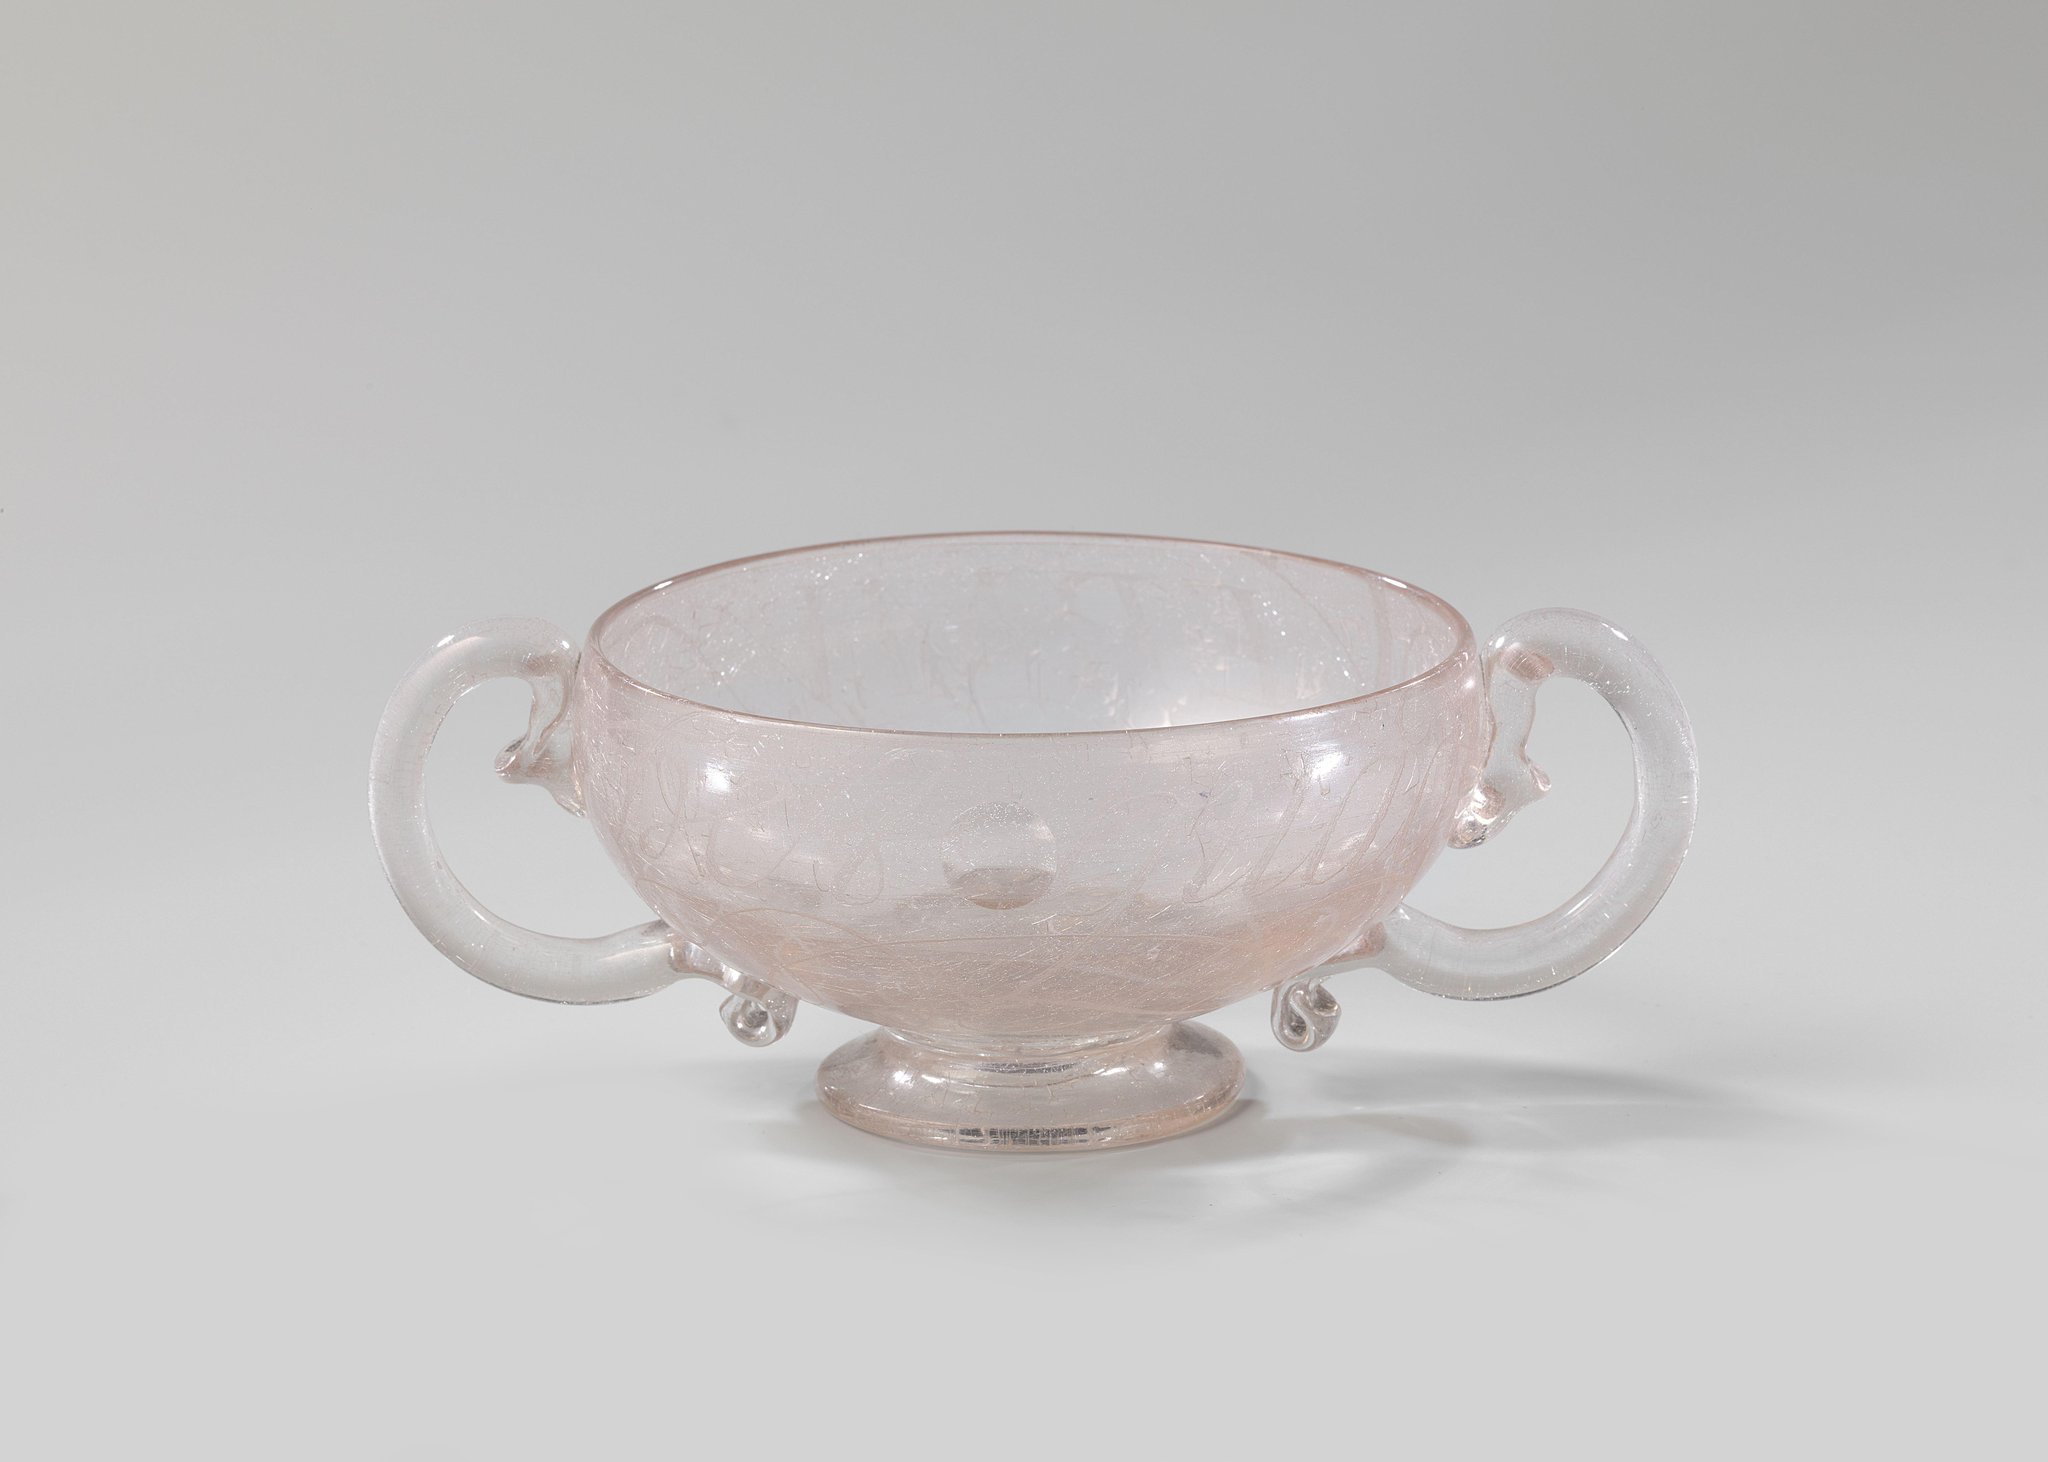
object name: dish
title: Schaal met oren op voet, met het opschrift: VERMEY het quade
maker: Anonymous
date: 1675-1700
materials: glass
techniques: diamond point engraving, glassblowing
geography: northern netherlands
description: Lage, aangezette voet. Kom met twee C-vormige, aangezette oren. Op het lichaam gecalligrafeerd opschrift: VERMY het quade. Tussen het woord 'het' en 'quade' is een lens geslepen. Op de onderzijde is een onleesbaar teken gegraveerd.